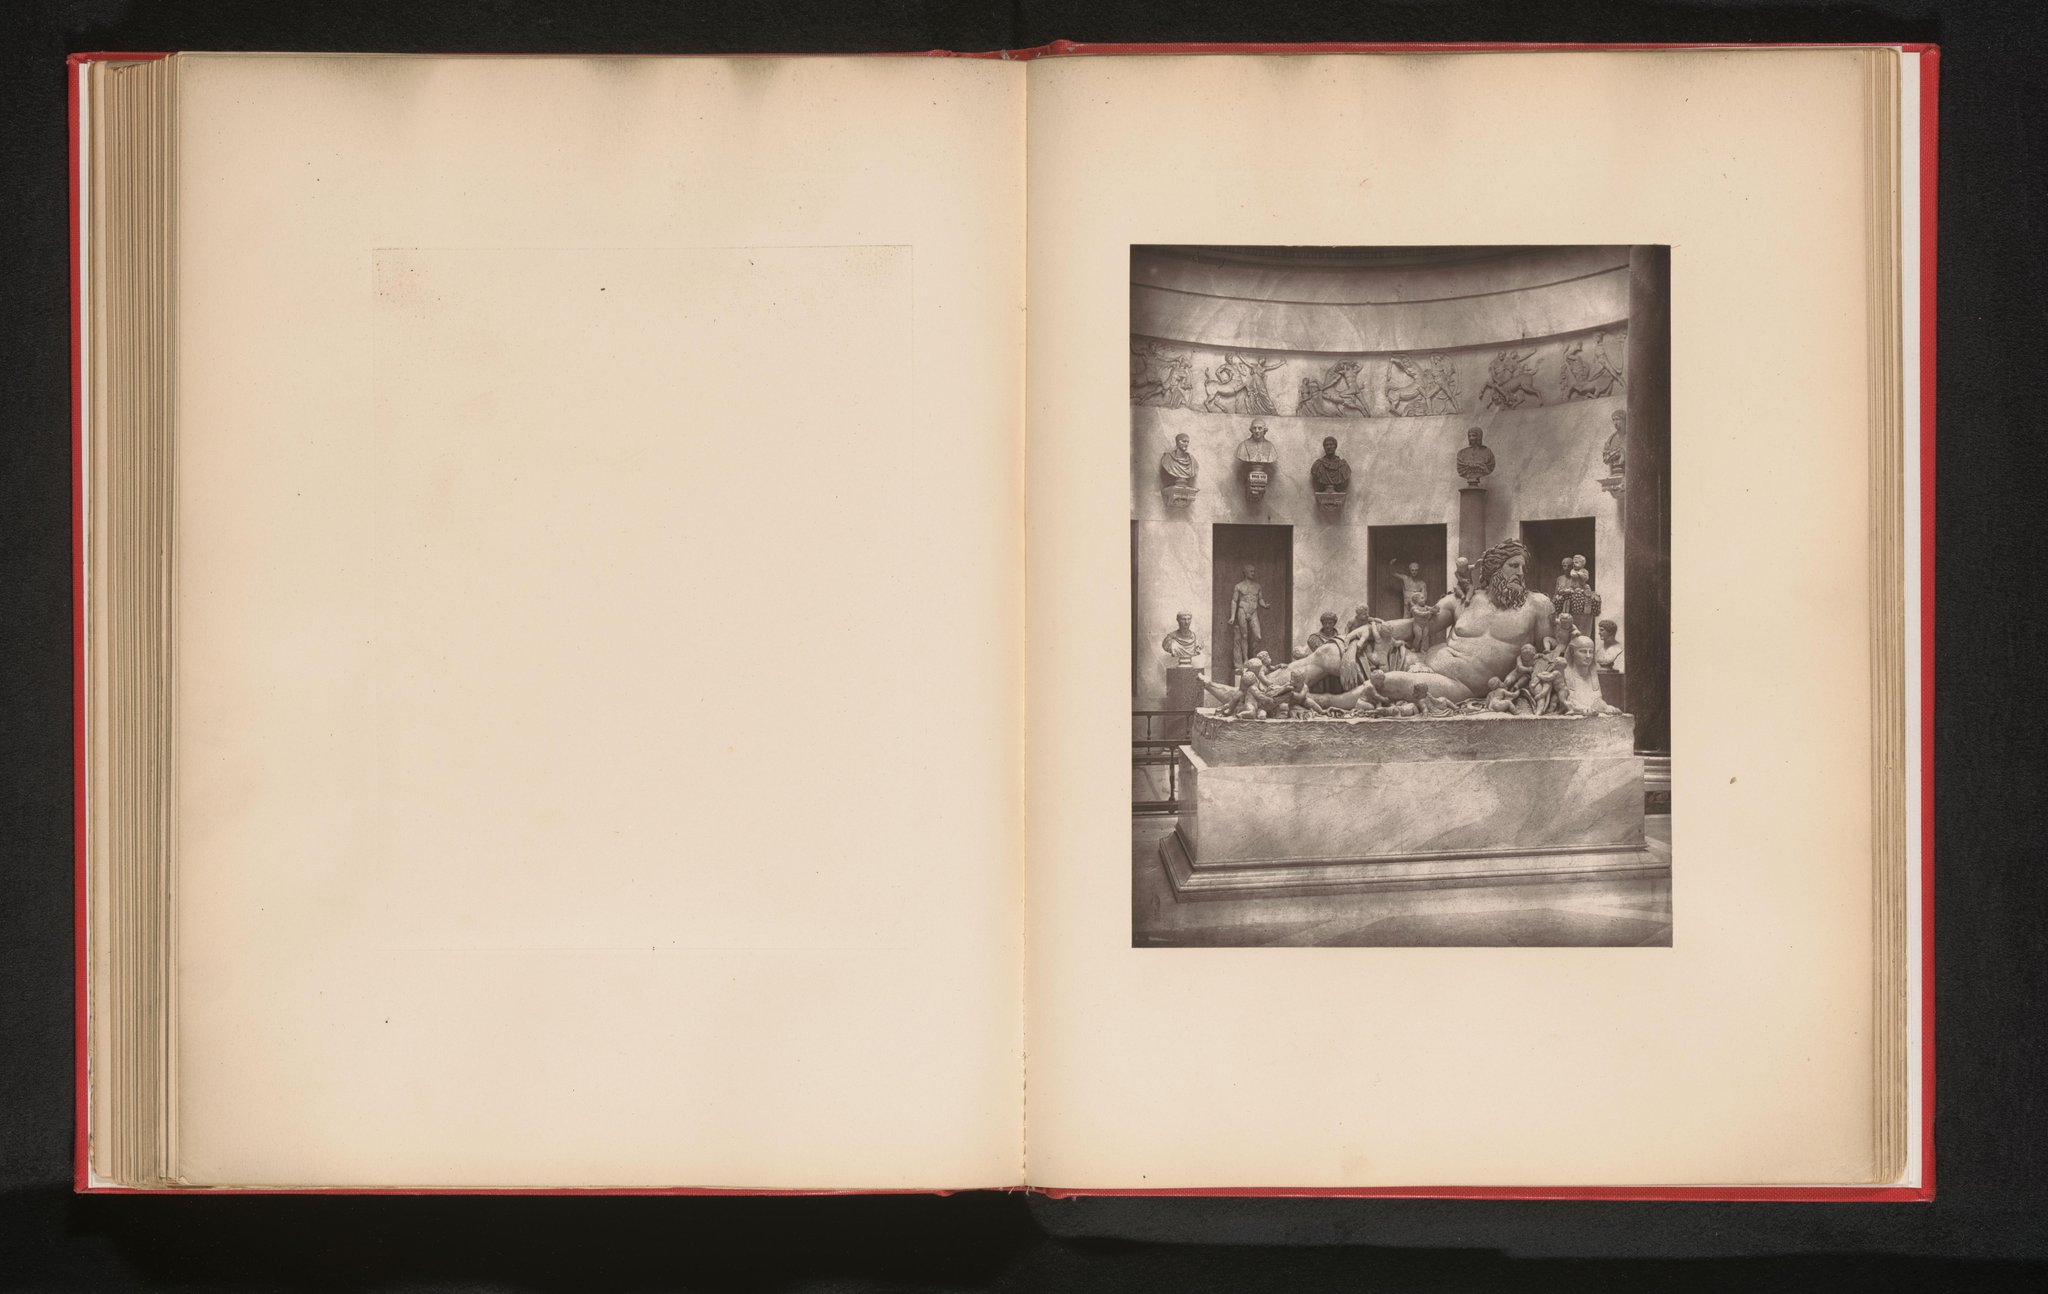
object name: page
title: Standbeeld van de personificatie van de Nijl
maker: stephen thompson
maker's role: fotograaf, schrijver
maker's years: 1831-1893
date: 1873-1878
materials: paper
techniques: woodburytype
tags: sculpture, personification of river nile; 'nilo' (ripa)